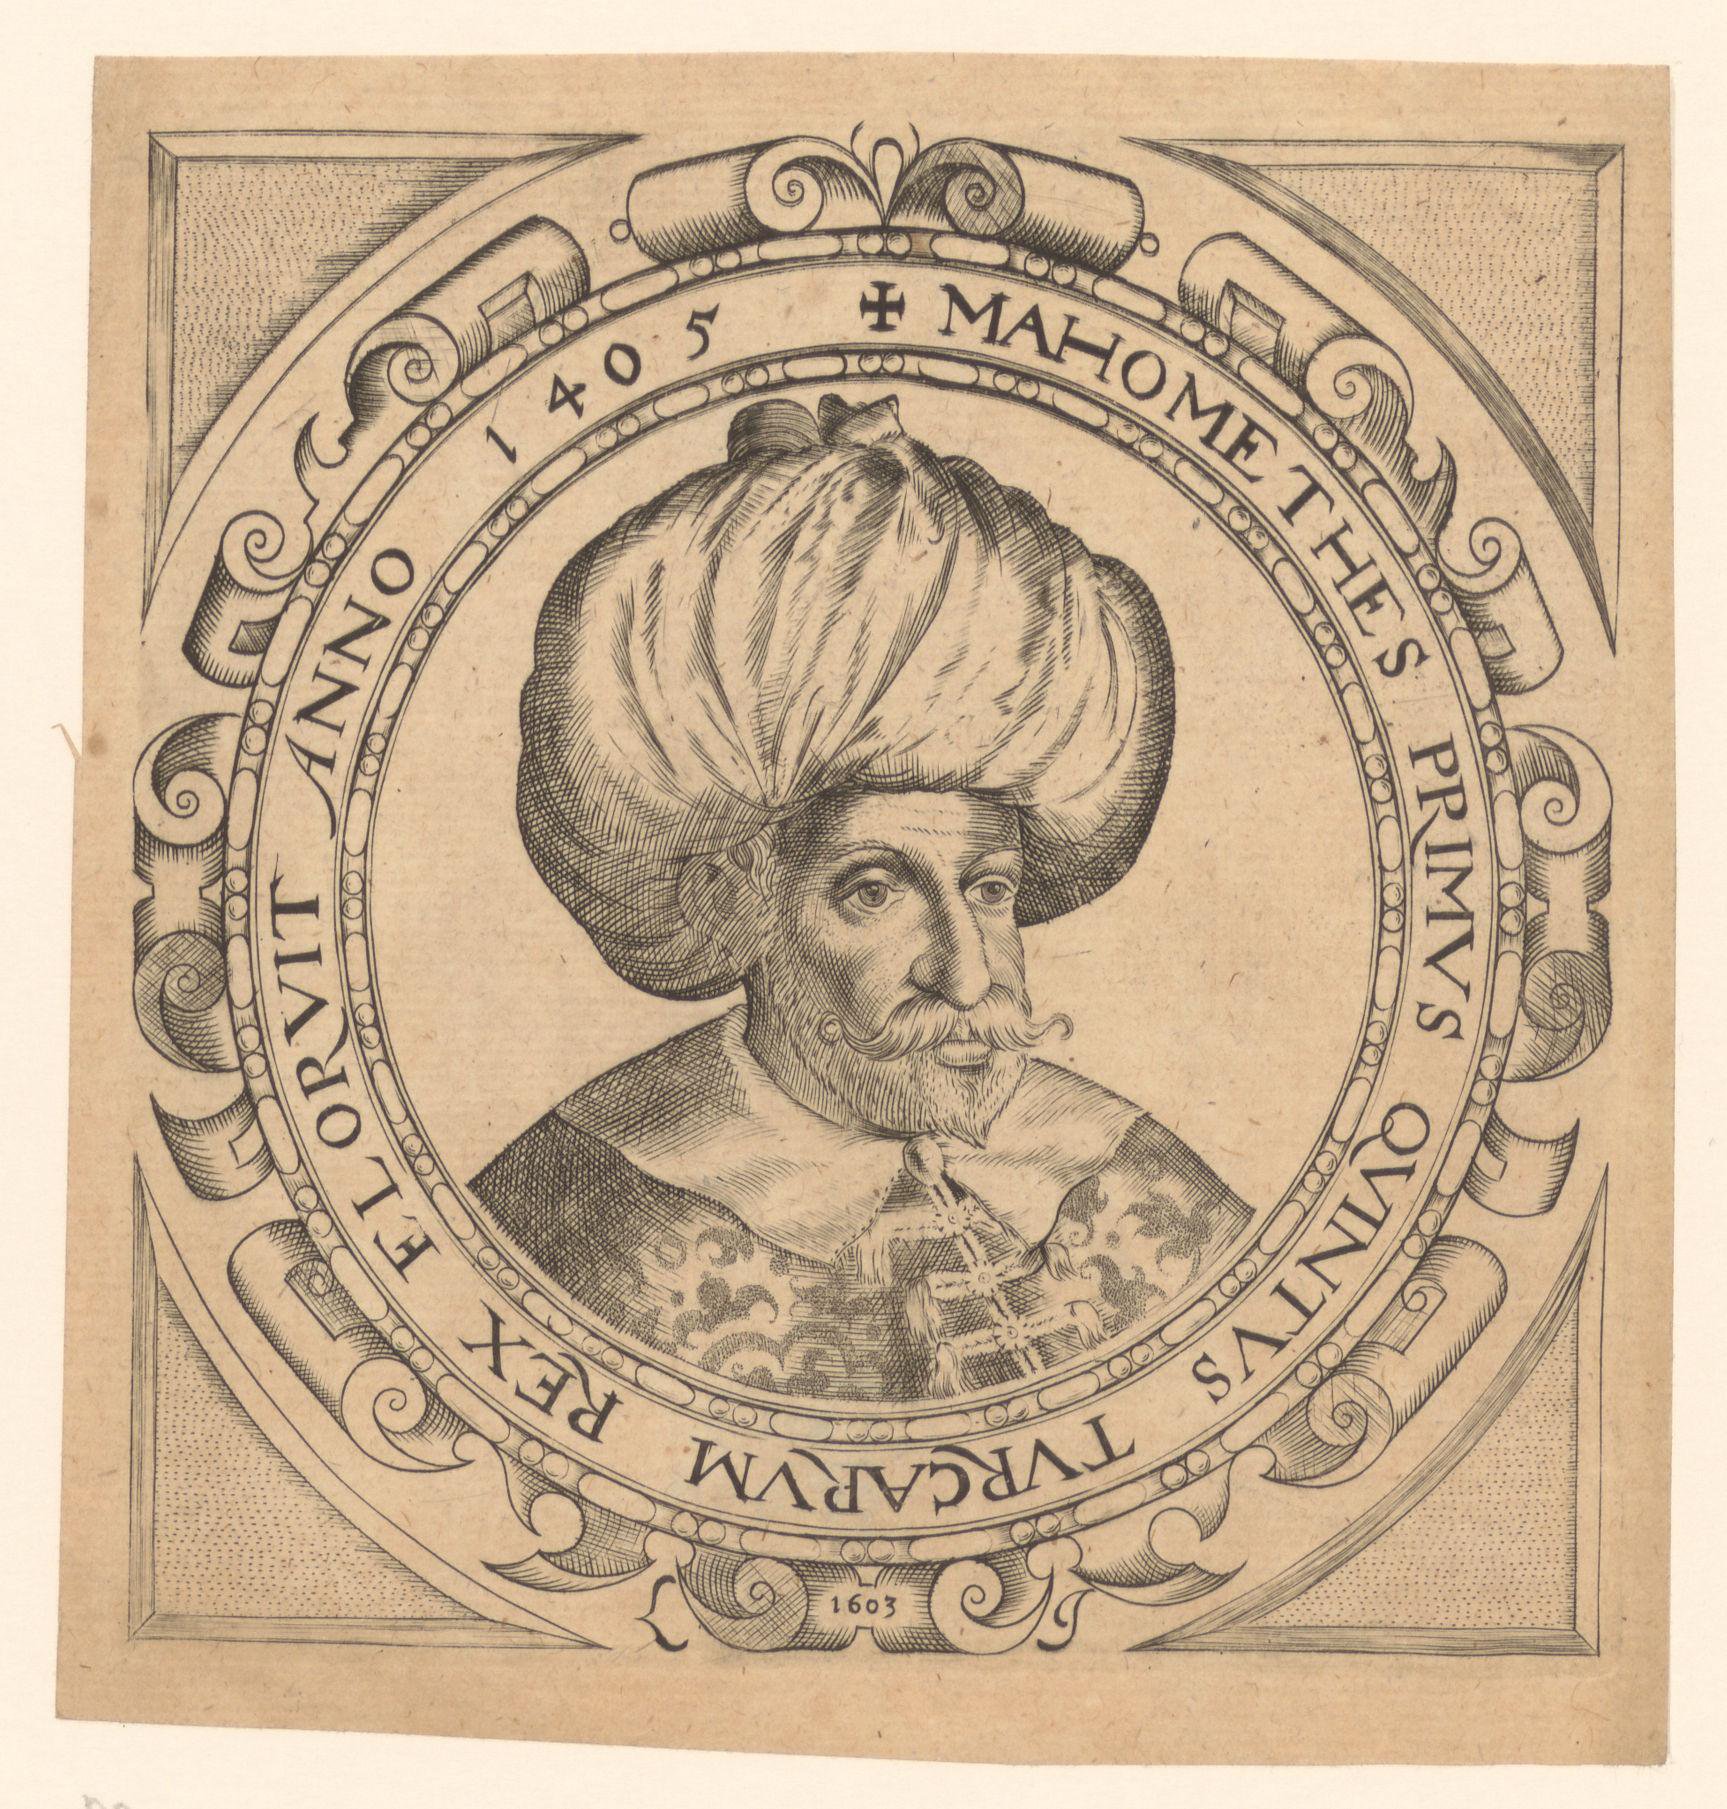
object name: print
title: Portret van sultan Mehmed I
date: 1603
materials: paper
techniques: engraving, letterpress printing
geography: london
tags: historical persons, ruler, sovereign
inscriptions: collector's mark: Lugt 2228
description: Prent gebruikt in: Knolles, Richard. The lives of the Othoman Kings and Emperors (...). Londen: Adam Islip, 1603. Prent ook gebruikt in: Knolles, Richard. The Generall Historie of the Turkes from the First Beginning of that Nation to the Rising of the Othoman Familie. Londen: Adam Islip, 1603.